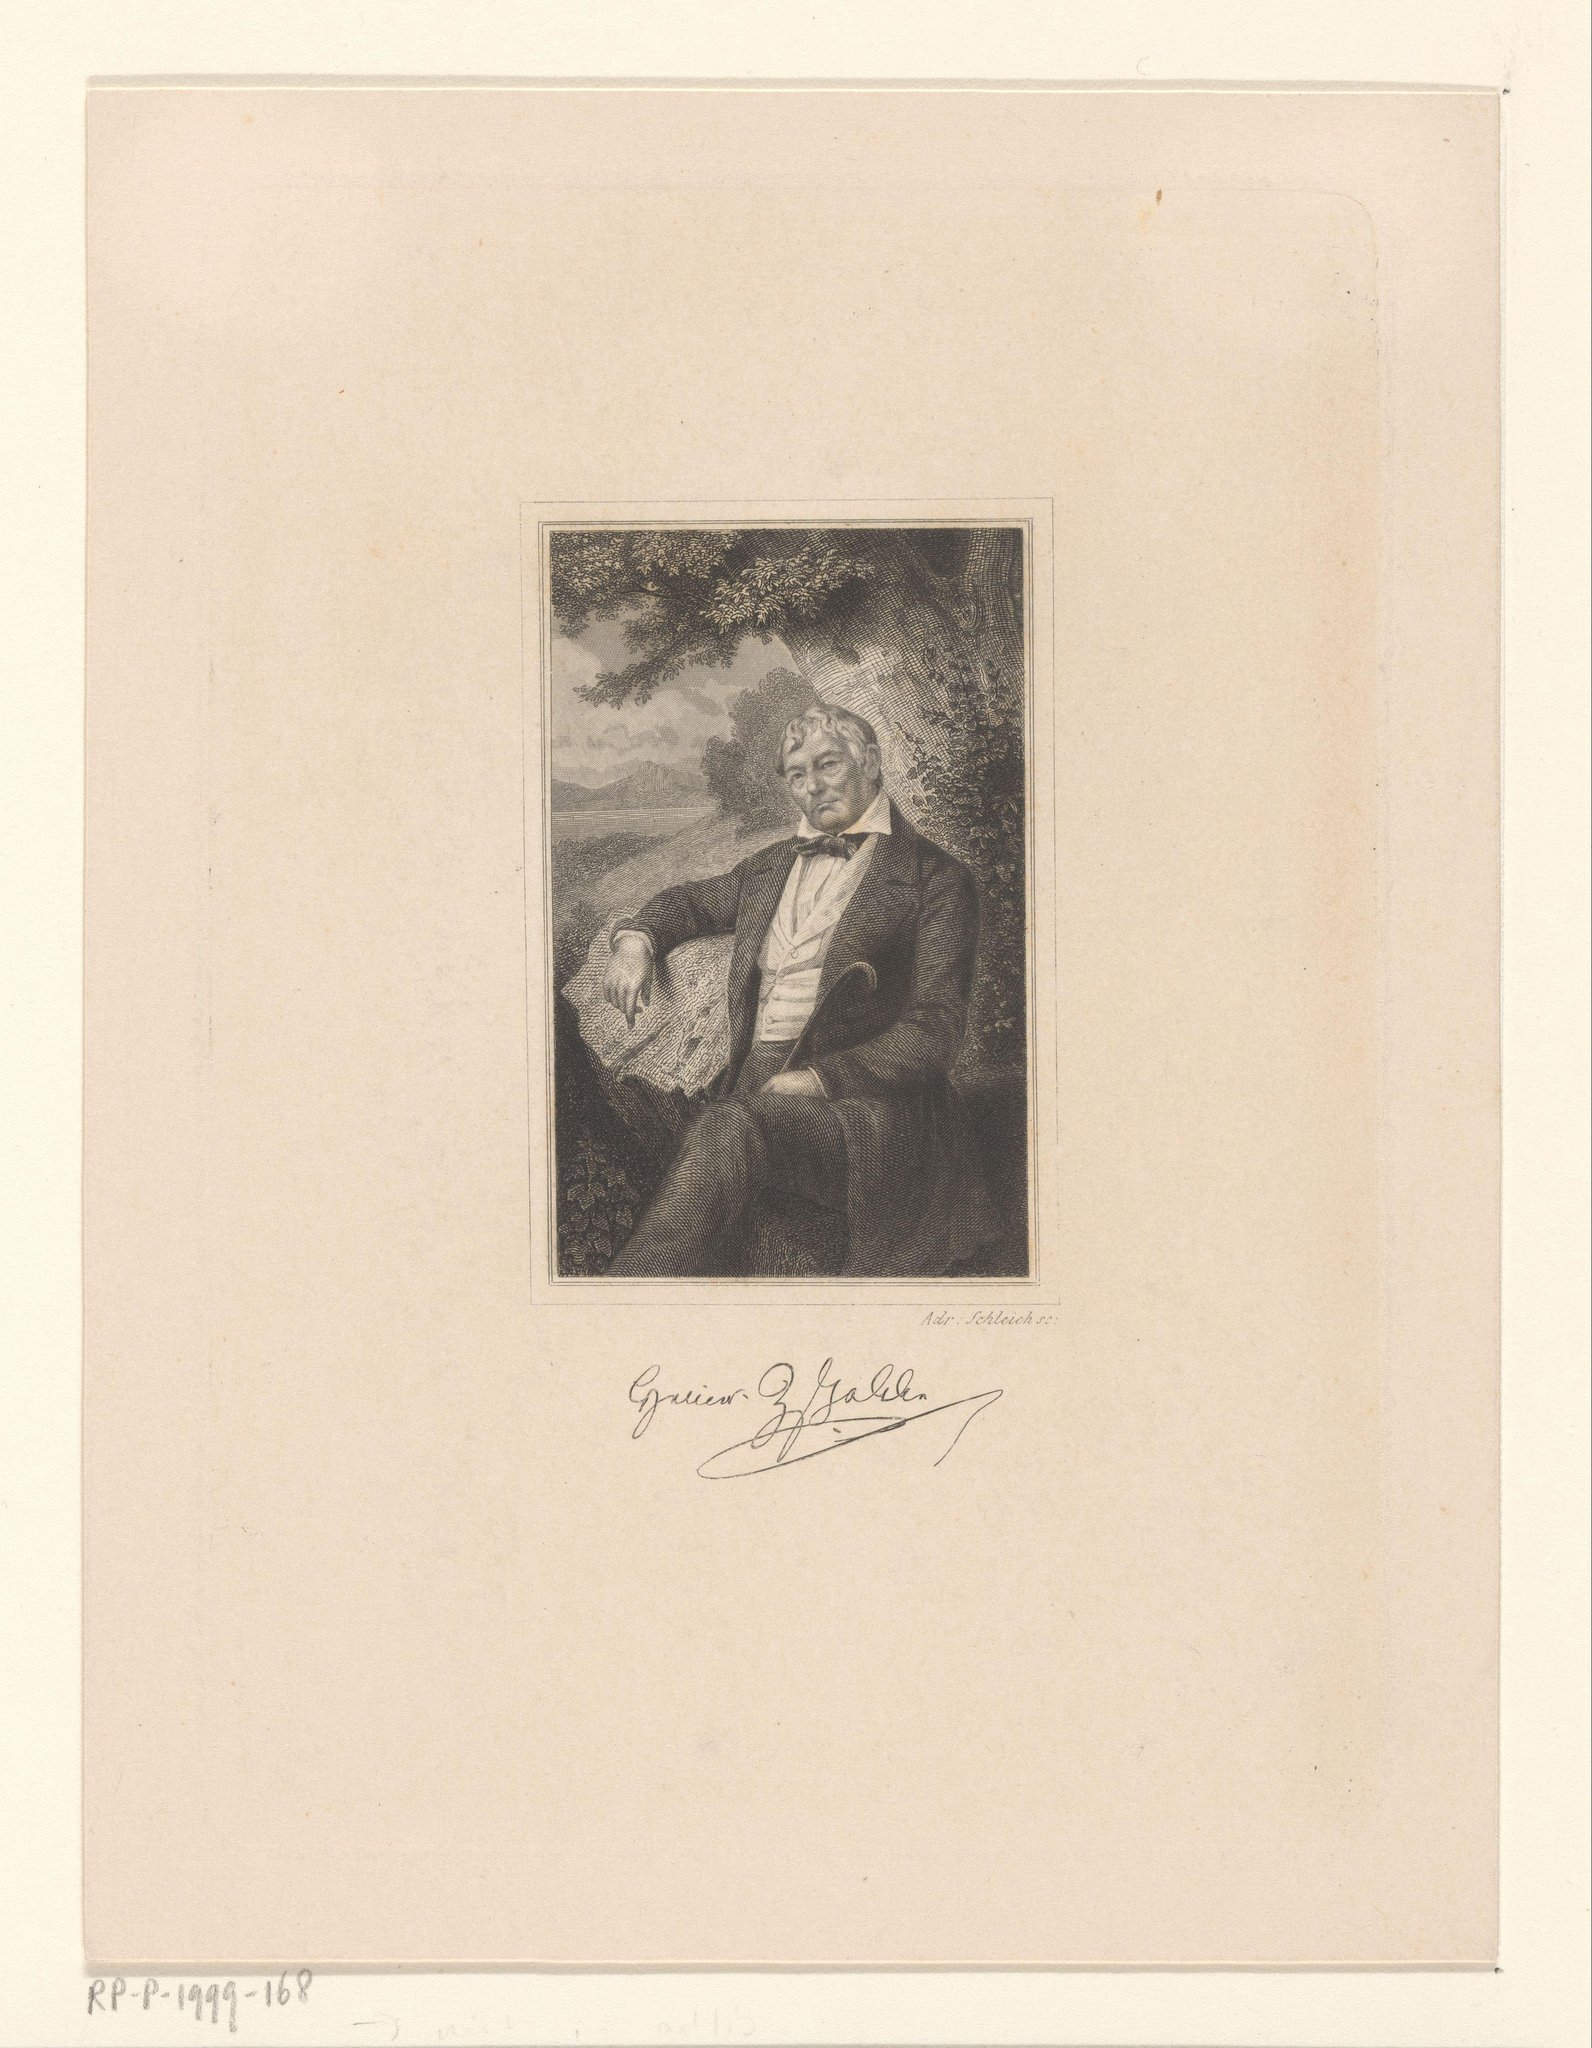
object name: print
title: Portret van Johann Heinrich Daniel Zschokke onder een boom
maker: adrian schleich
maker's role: print maker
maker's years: 1812-1894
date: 1822-1894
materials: paper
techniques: engraving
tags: historical persons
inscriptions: collector's mark: Lugt 2760, collector's mark: Lugt 2228